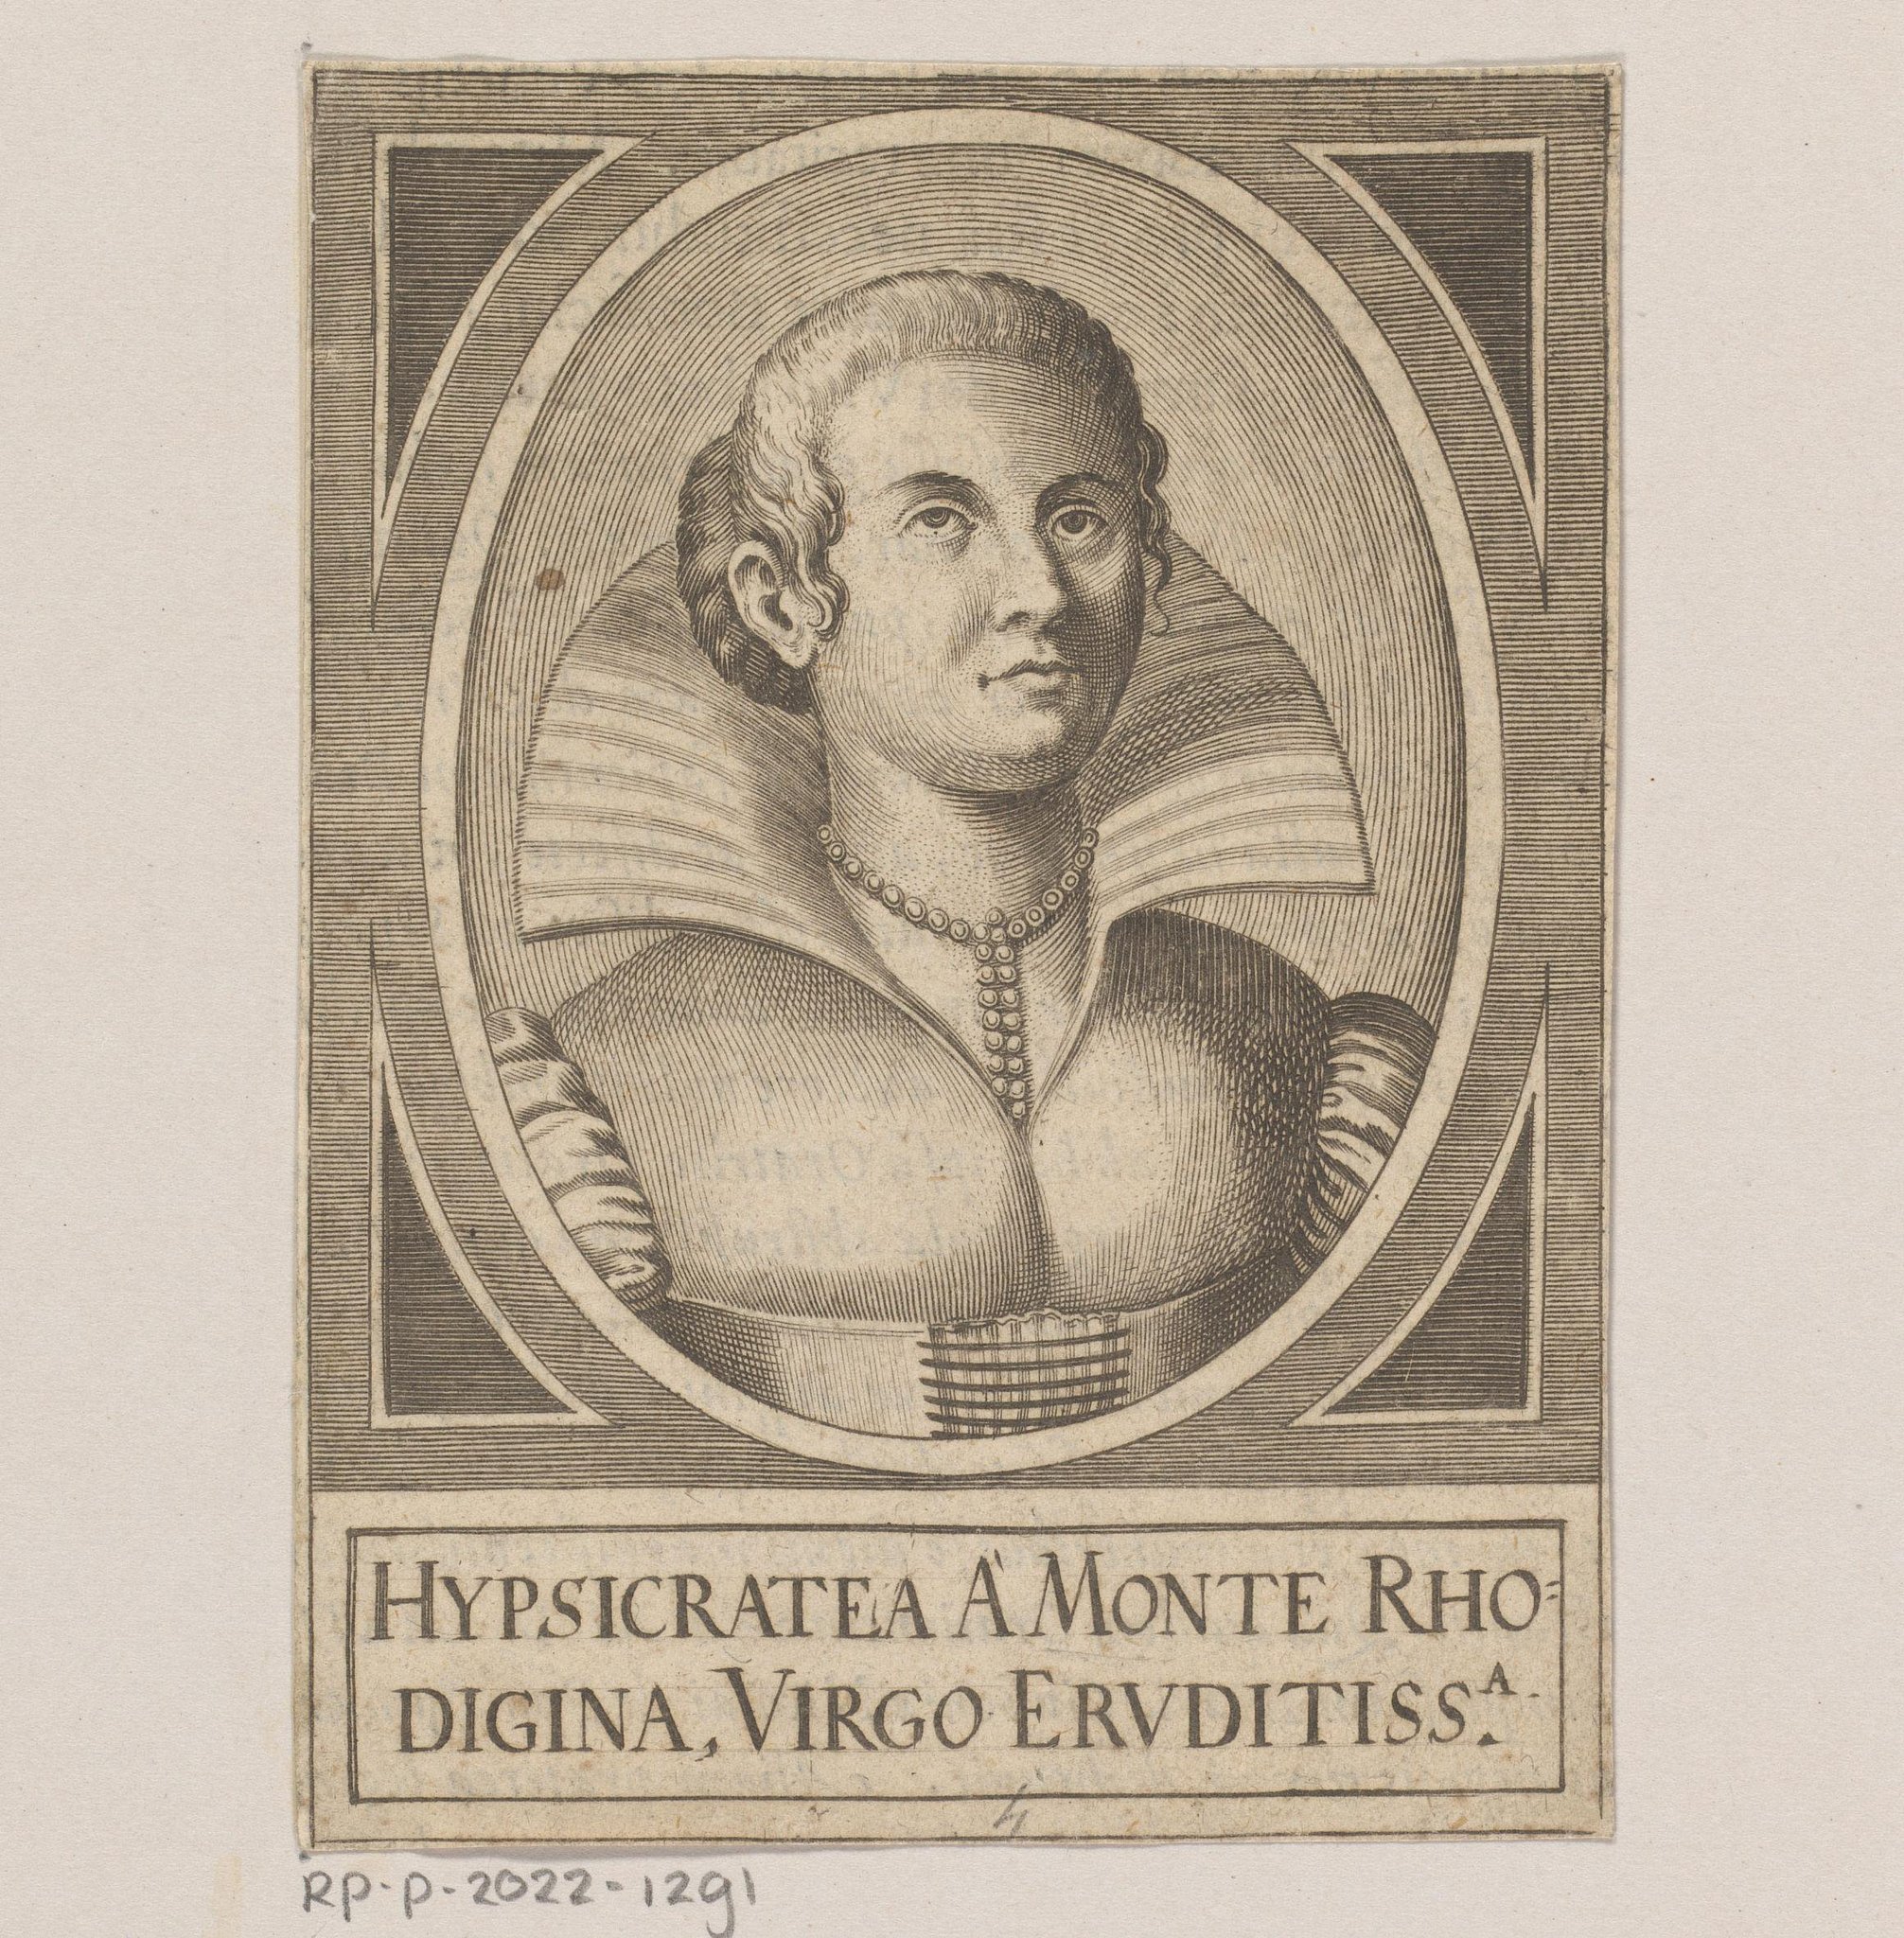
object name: print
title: Portret van Hypsicratea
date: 1644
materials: paper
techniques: engraving, letterpress printing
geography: padua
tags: historical persons - bb - woman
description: Prent uit: Tomasini, Giacomo Filippo. Iacobi Philippi Tomasini Patauini Elogia virorum literis & sapientia illustrium ad viuum expressis imaginibus exornata. (...) Padua: Sebastiano Sardi, 1644, p. 365.